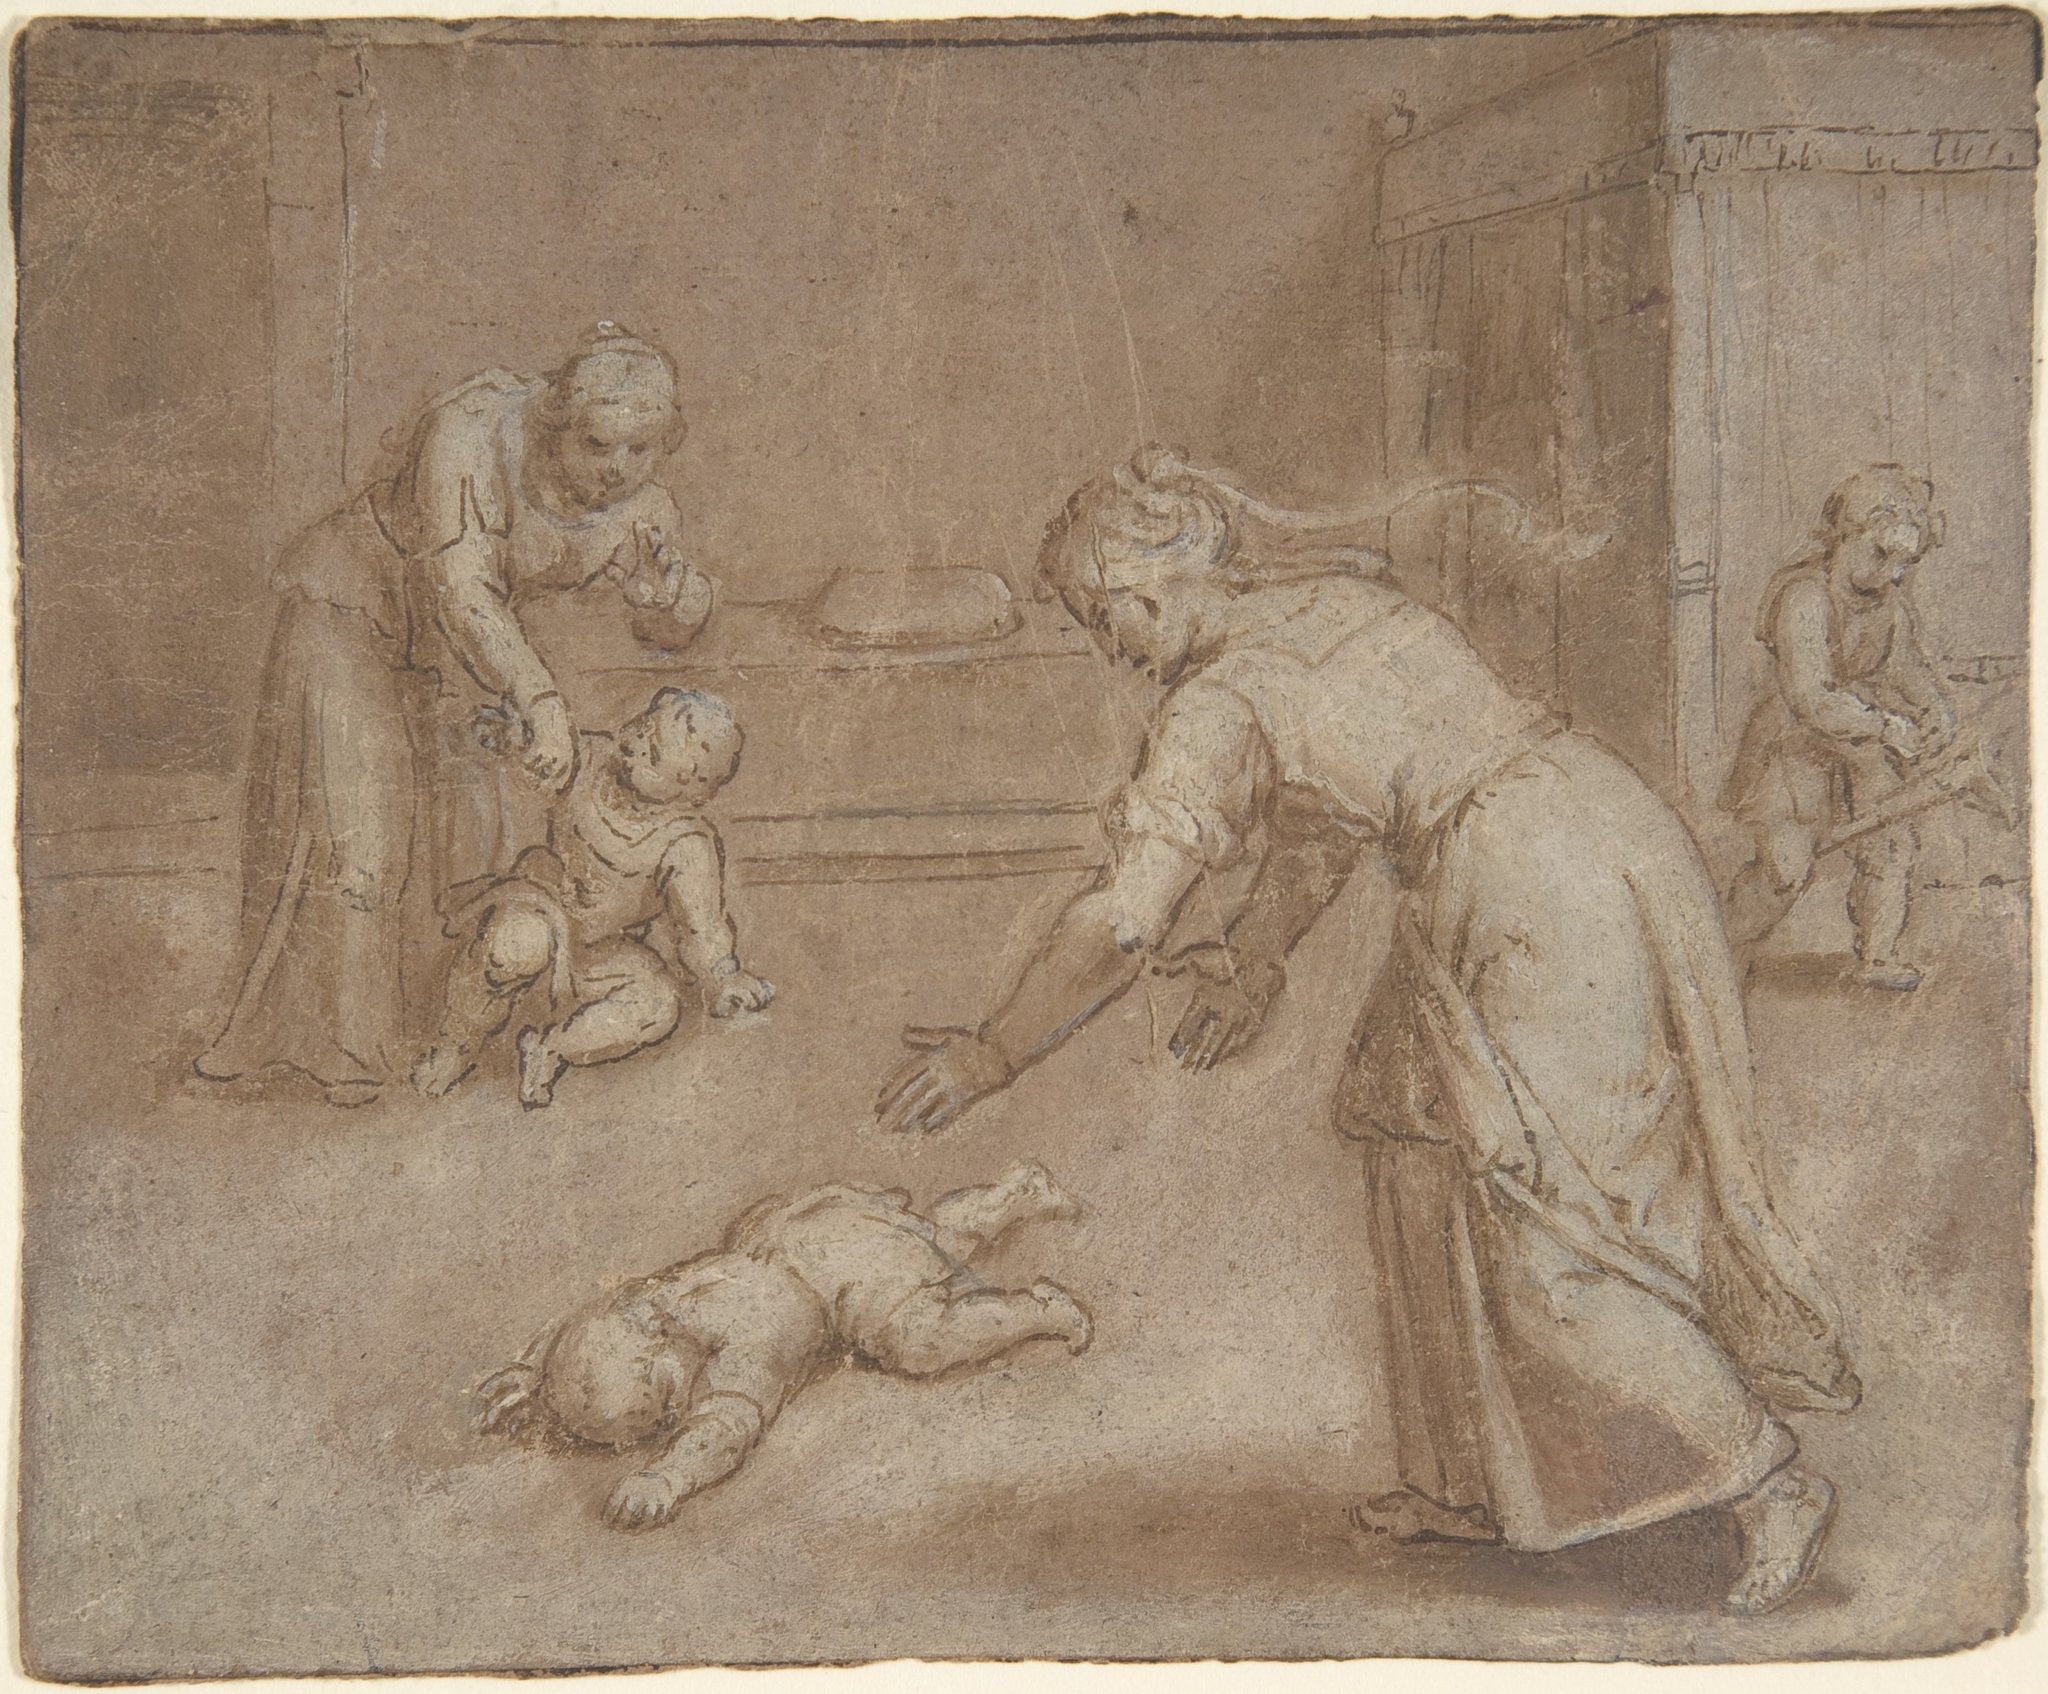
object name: drawing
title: Two women and three children in an interior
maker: otto van veen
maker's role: artist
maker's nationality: netherlandish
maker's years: 1556-1629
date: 1556-1629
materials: ink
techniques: brush, pen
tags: interiors,children,women